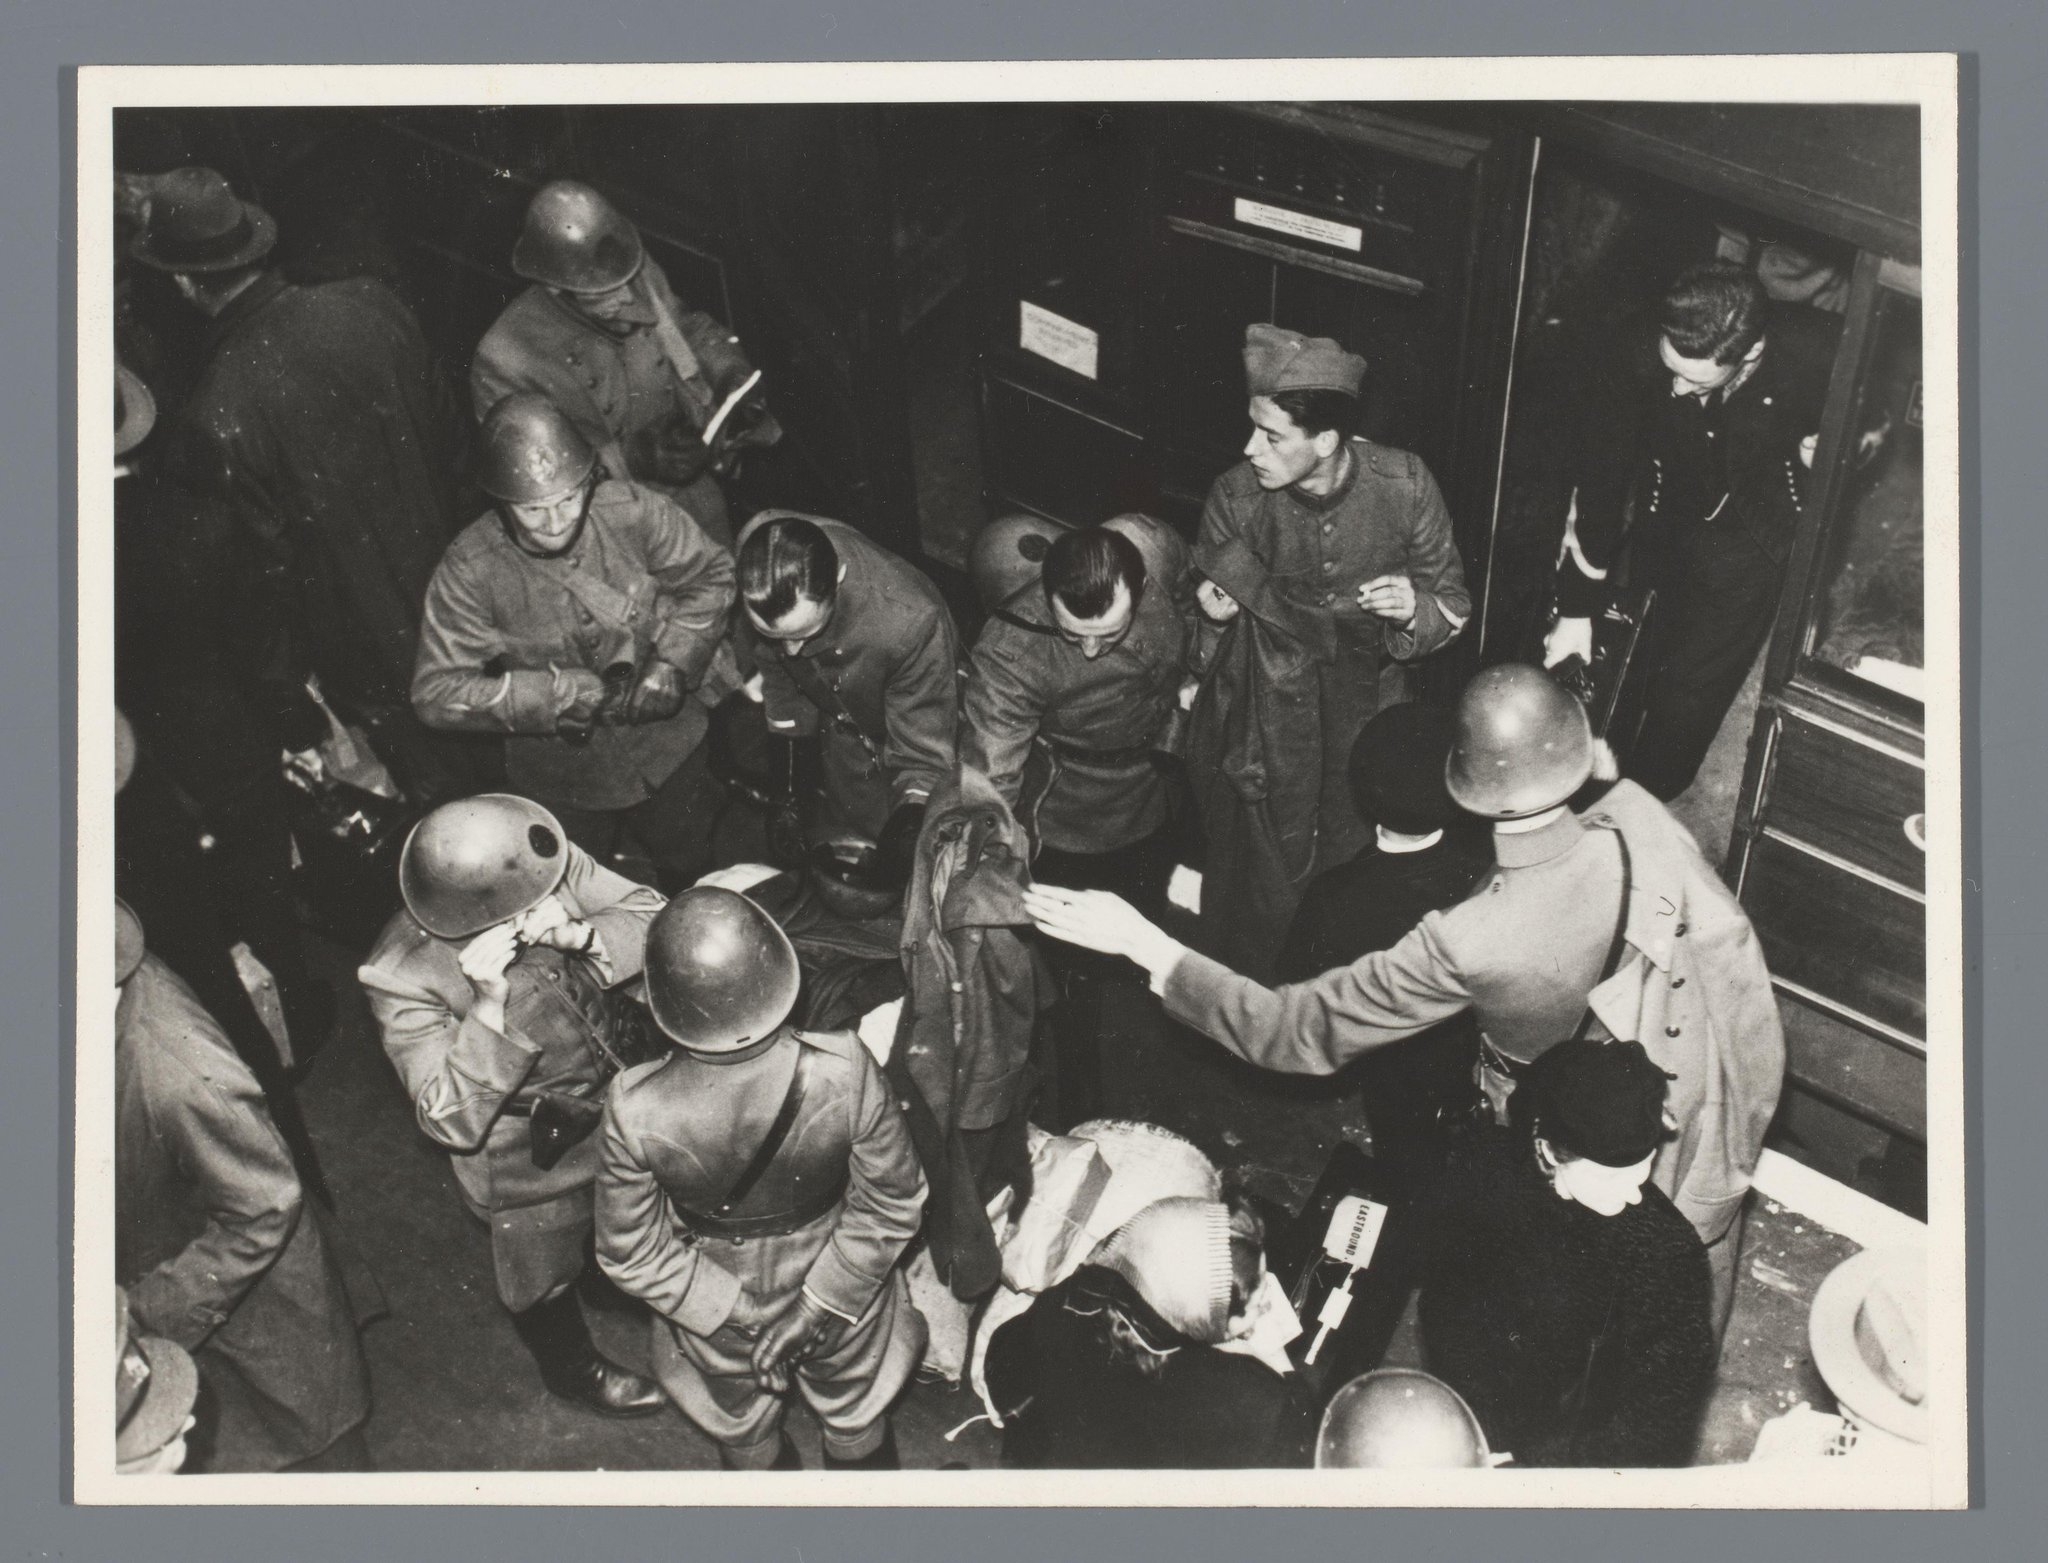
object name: photograph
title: Nederlandse soldaten in Londen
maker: Anonymous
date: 1940-1944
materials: ink, paper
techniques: photography, writing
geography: london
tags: england